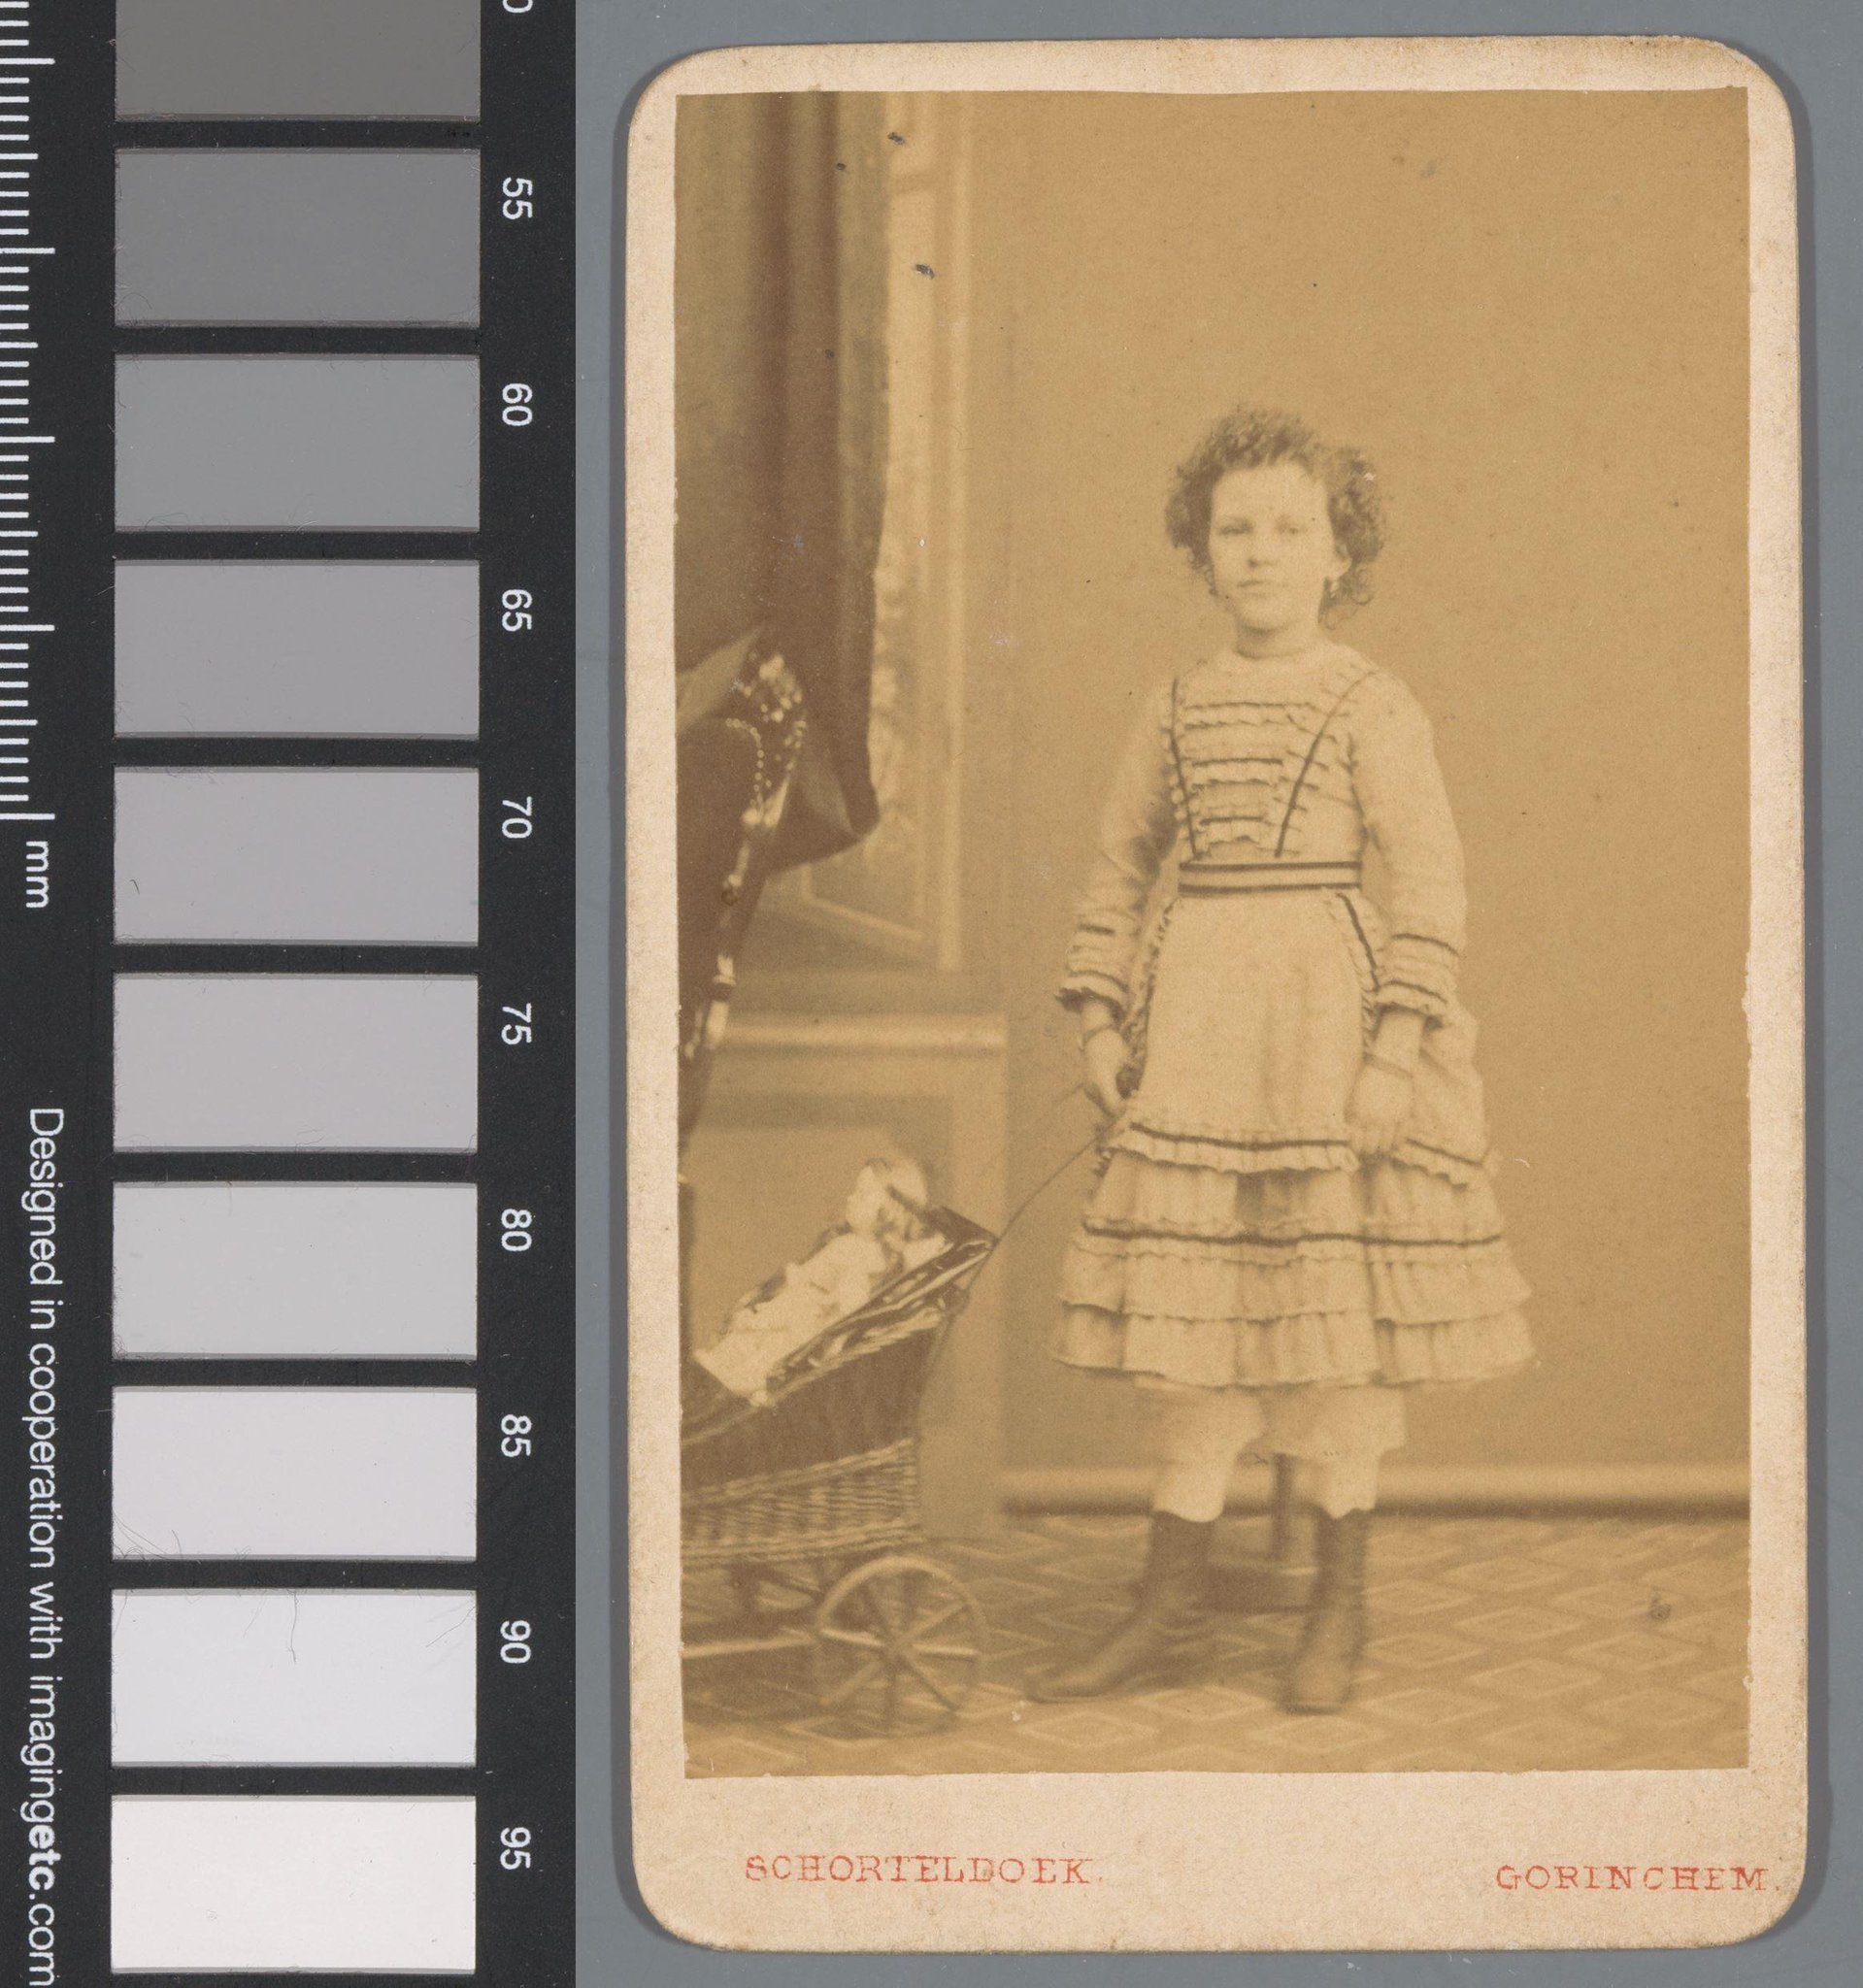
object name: photograph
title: Portret van een onbekend meisje met poppenwagen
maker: kornelis willem schorteldoek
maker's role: boekbinder, fotograaf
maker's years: 1800-1885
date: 1865-1885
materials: cardboard, paper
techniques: albumen print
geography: gorinchem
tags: girl (child between toddler and youth), anonymous historical person portrayed, (playing with) dolls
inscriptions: inscription: ‘Schorteldoek/ Photograaf./ Gorinchem’, inscription: ‘Schorteldoek. Gorinchem.’, inscription: ‘wat een brutaal/ nest niet?/ steeds met een pop.’